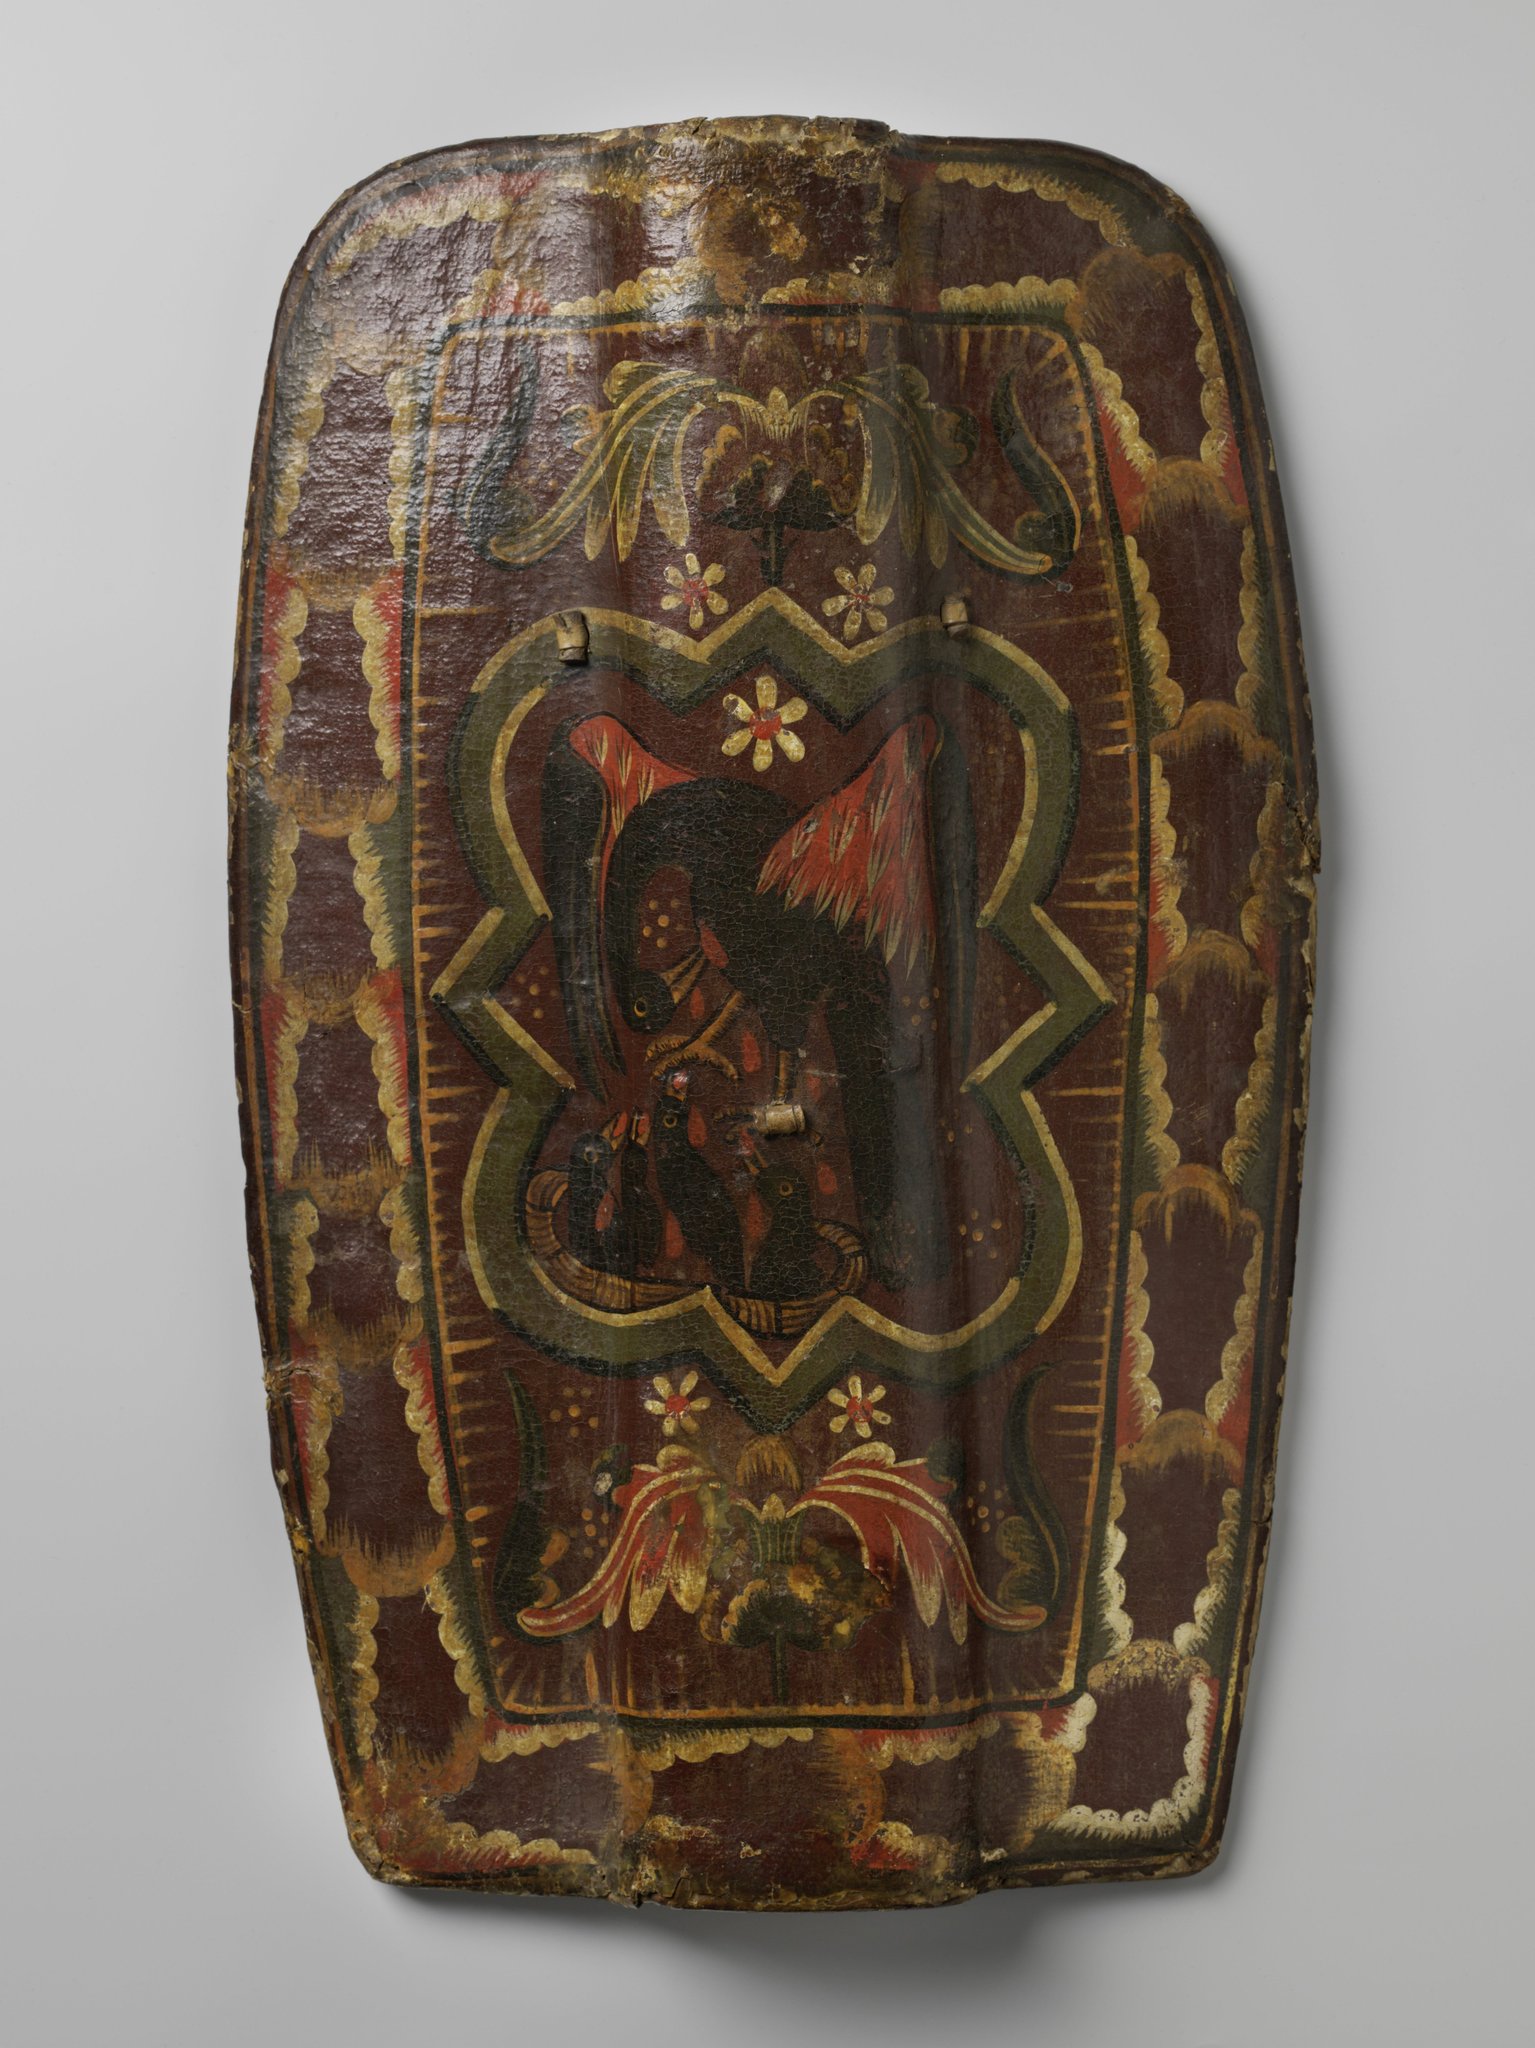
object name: shield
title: Vijftiende-eeuws Duits schild, beschilderd met een pelikaan met haar jongen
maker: Anonymous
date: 1400-1500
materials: iron, leather, linen, wood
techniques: braiding, woodworking, painted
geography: europe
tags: armorial bearing, heraldry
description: Langwerpig vijftiende-eeuws Duits schild, vermoedelijk een voetknechtenschild, met concave zijkanten. In het midden van boven naar beneden loopt een verhoging van 13 cm breed. Geheel overtrokken met donkerrood leer, de voorzijde beschilderd met de voorstelling van een zwarte pelikaan, zich in de borst prikkend met zijn snavel boven een nest met vier jongen die zich voeden met de vallende druppels bloed. In een vierlobbige omlijsting, omgeven door plant-, bloem- en abstracte motieven. Op drie plaatsen gaten in het schild, waardoor riempjes van het handvat komen, vastgehouden door dikke stukjes leer. Het handvat aan de keerzijde bestaat uit een verticaal stuk hout, boven doorboord met een horizontaal stokje, het geheel omwonden door een leren riempje, plaastelijk gevlochten. Twee spijkers houden een tweede leren riempje vast, dat aan één kant is afgebroken.